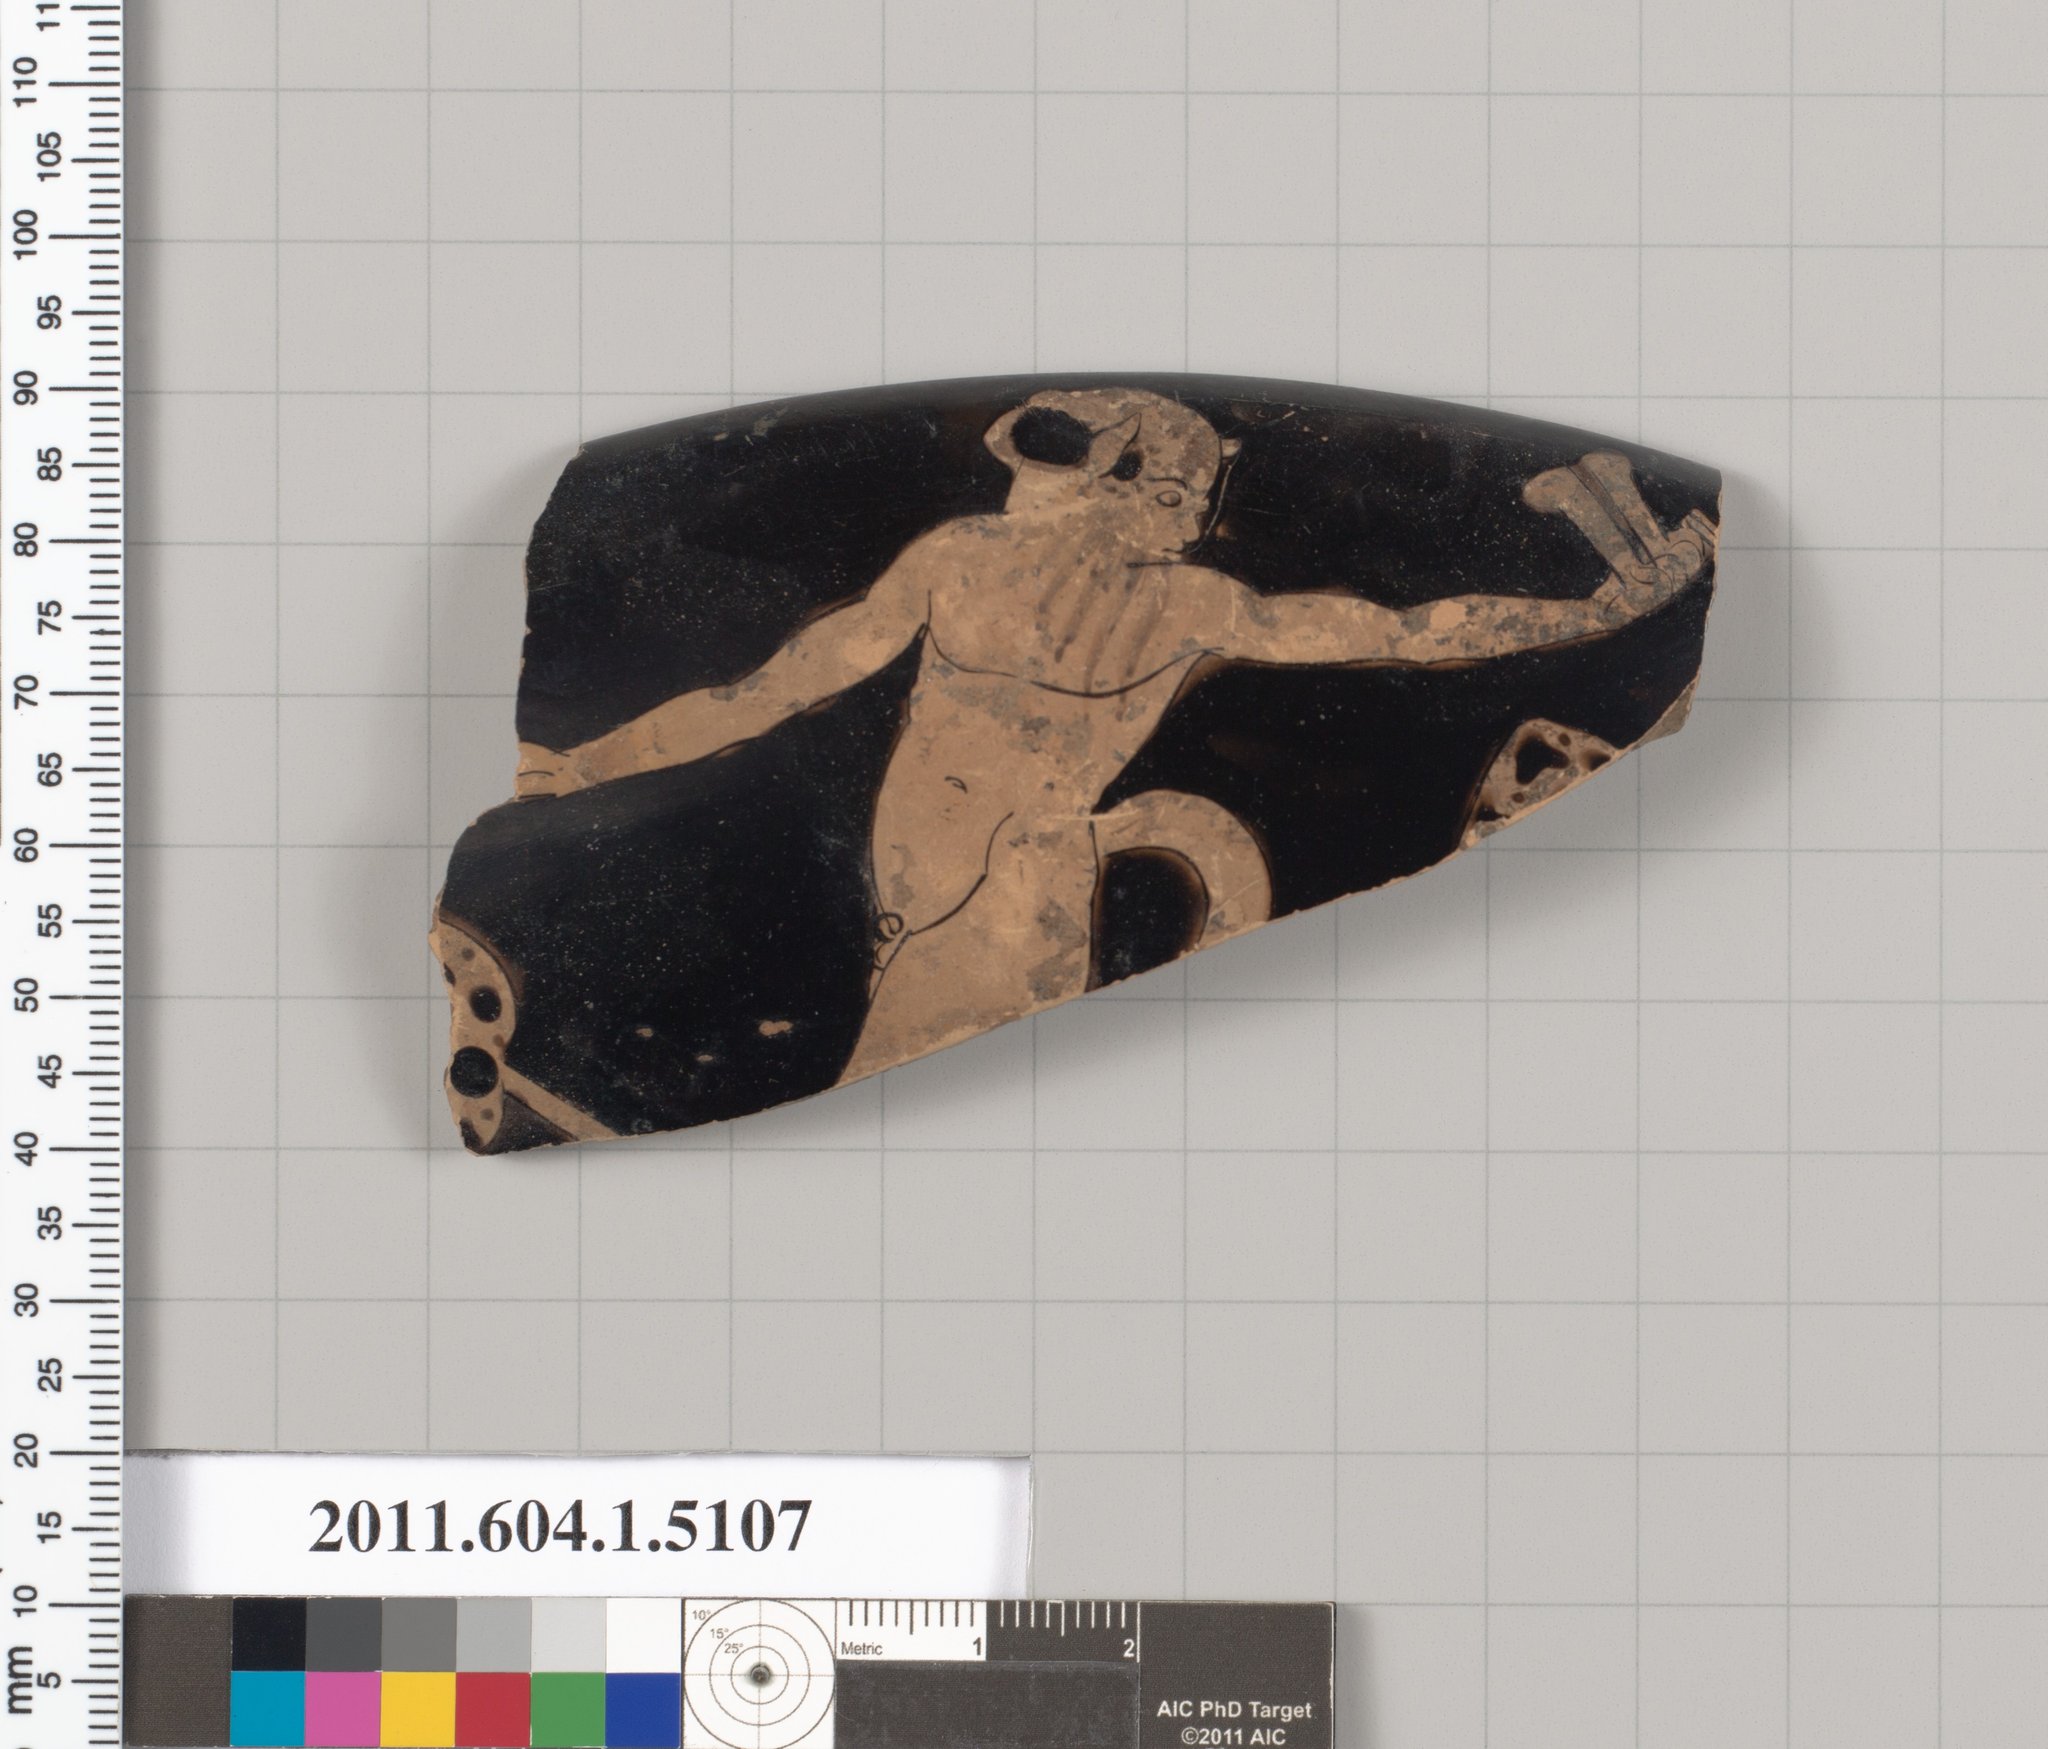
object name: kylix fragment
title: Terracotta rim fragment of a kylix (drinking cup)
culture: greek, attic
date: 510-500 BCE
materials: terracotta